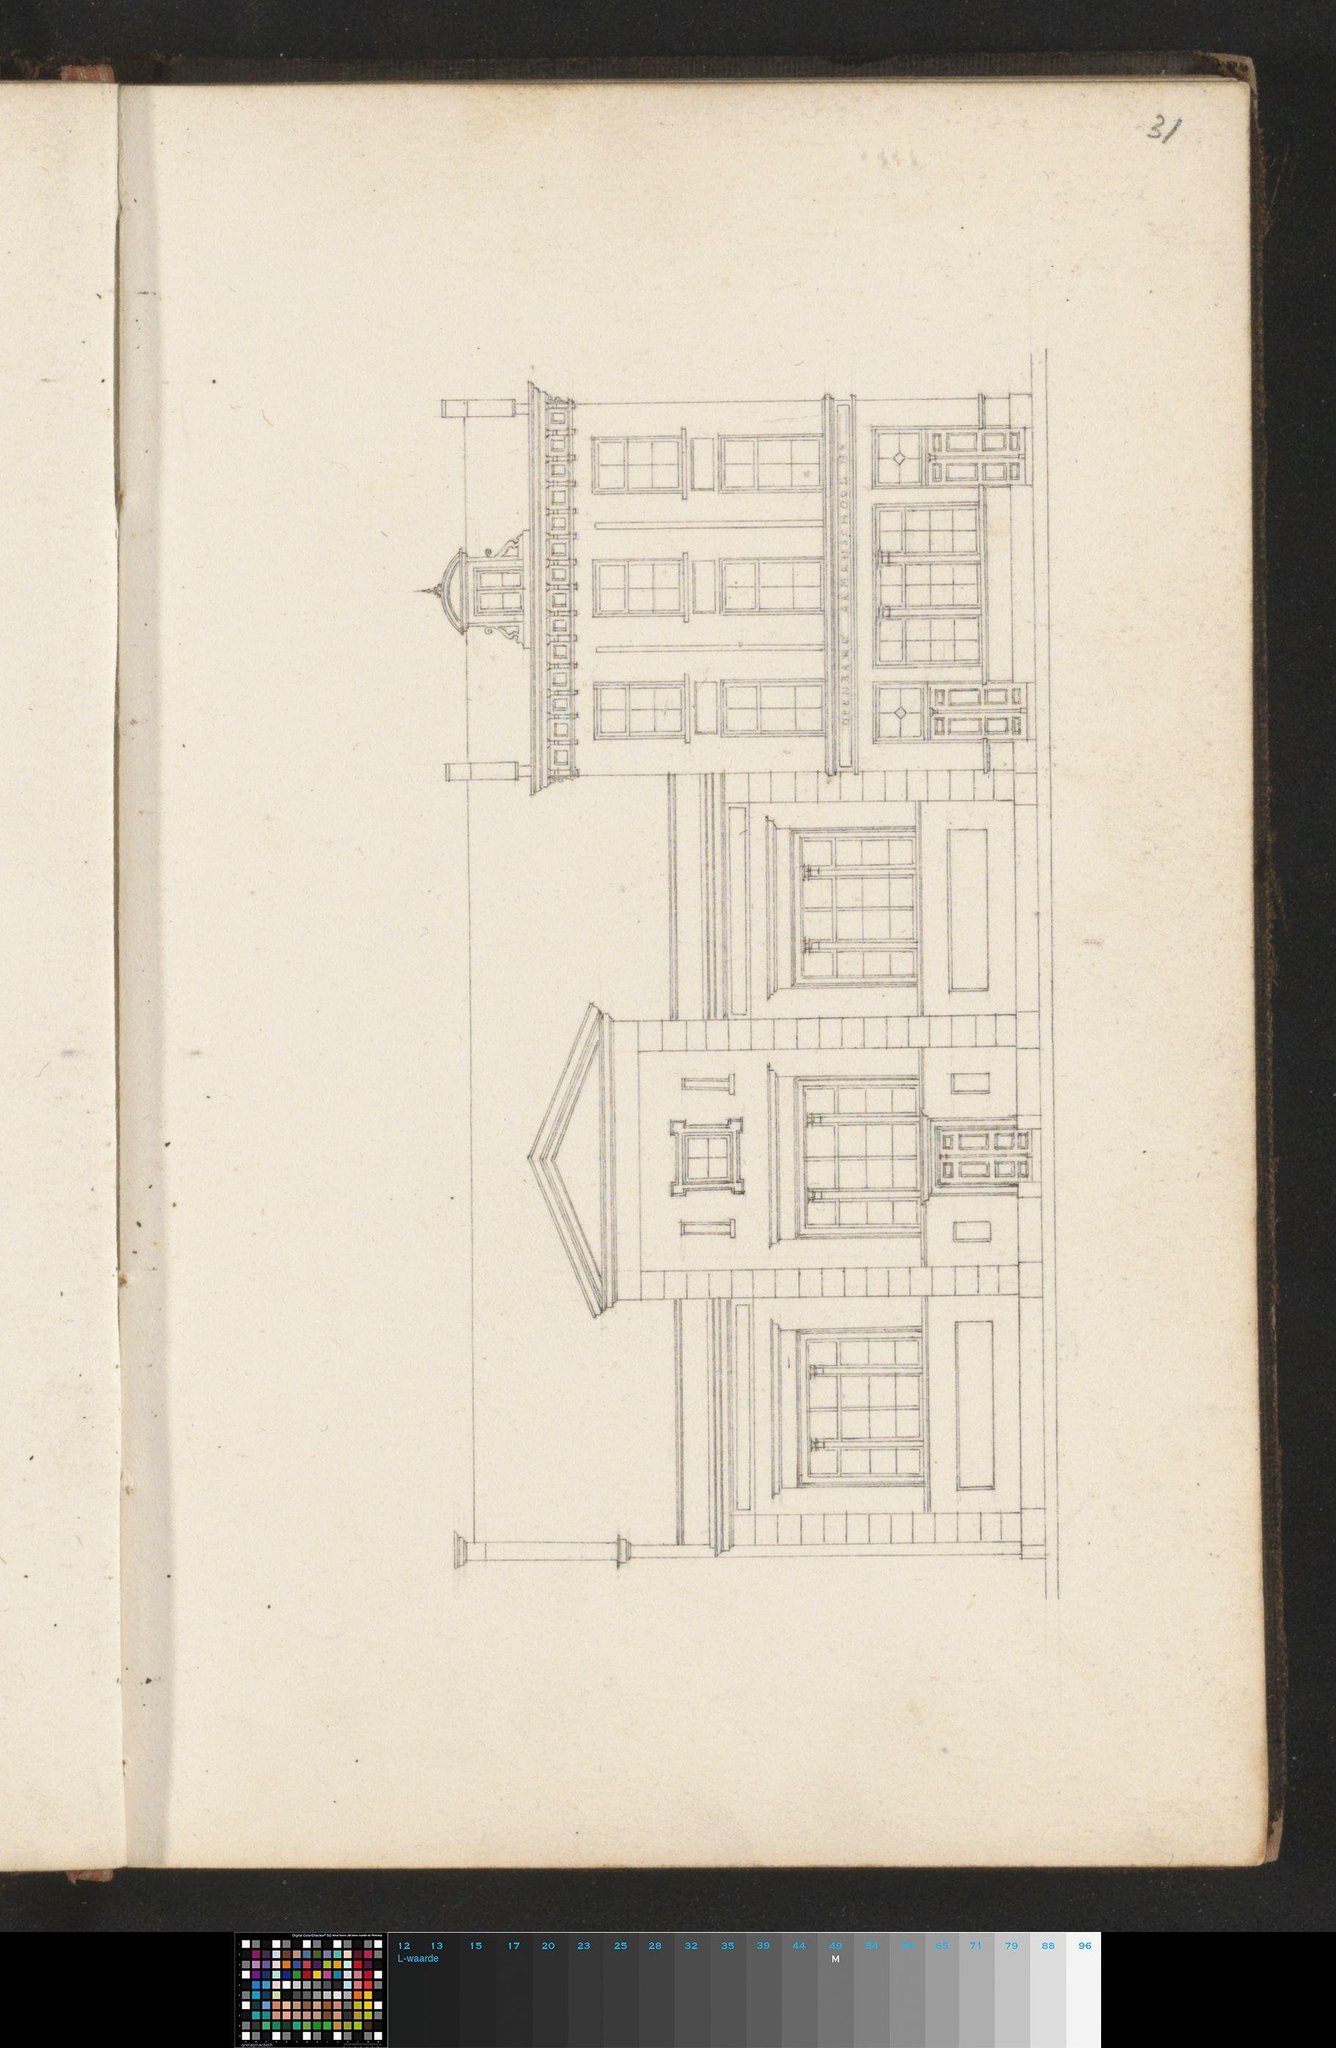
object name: sketchbook leaf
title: Opstand van de façade van een armenschool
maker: willem springer jr.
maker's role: draughtsman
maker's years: 1815-1907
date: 1864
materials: ink, paper, pencil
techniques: pen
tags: façade (of house or building)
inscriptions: annotation: ‘[...]EENBAN[...] ARMENSCHOOL’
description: Pagina 31 uit een schetsboek met 164 pagina's.